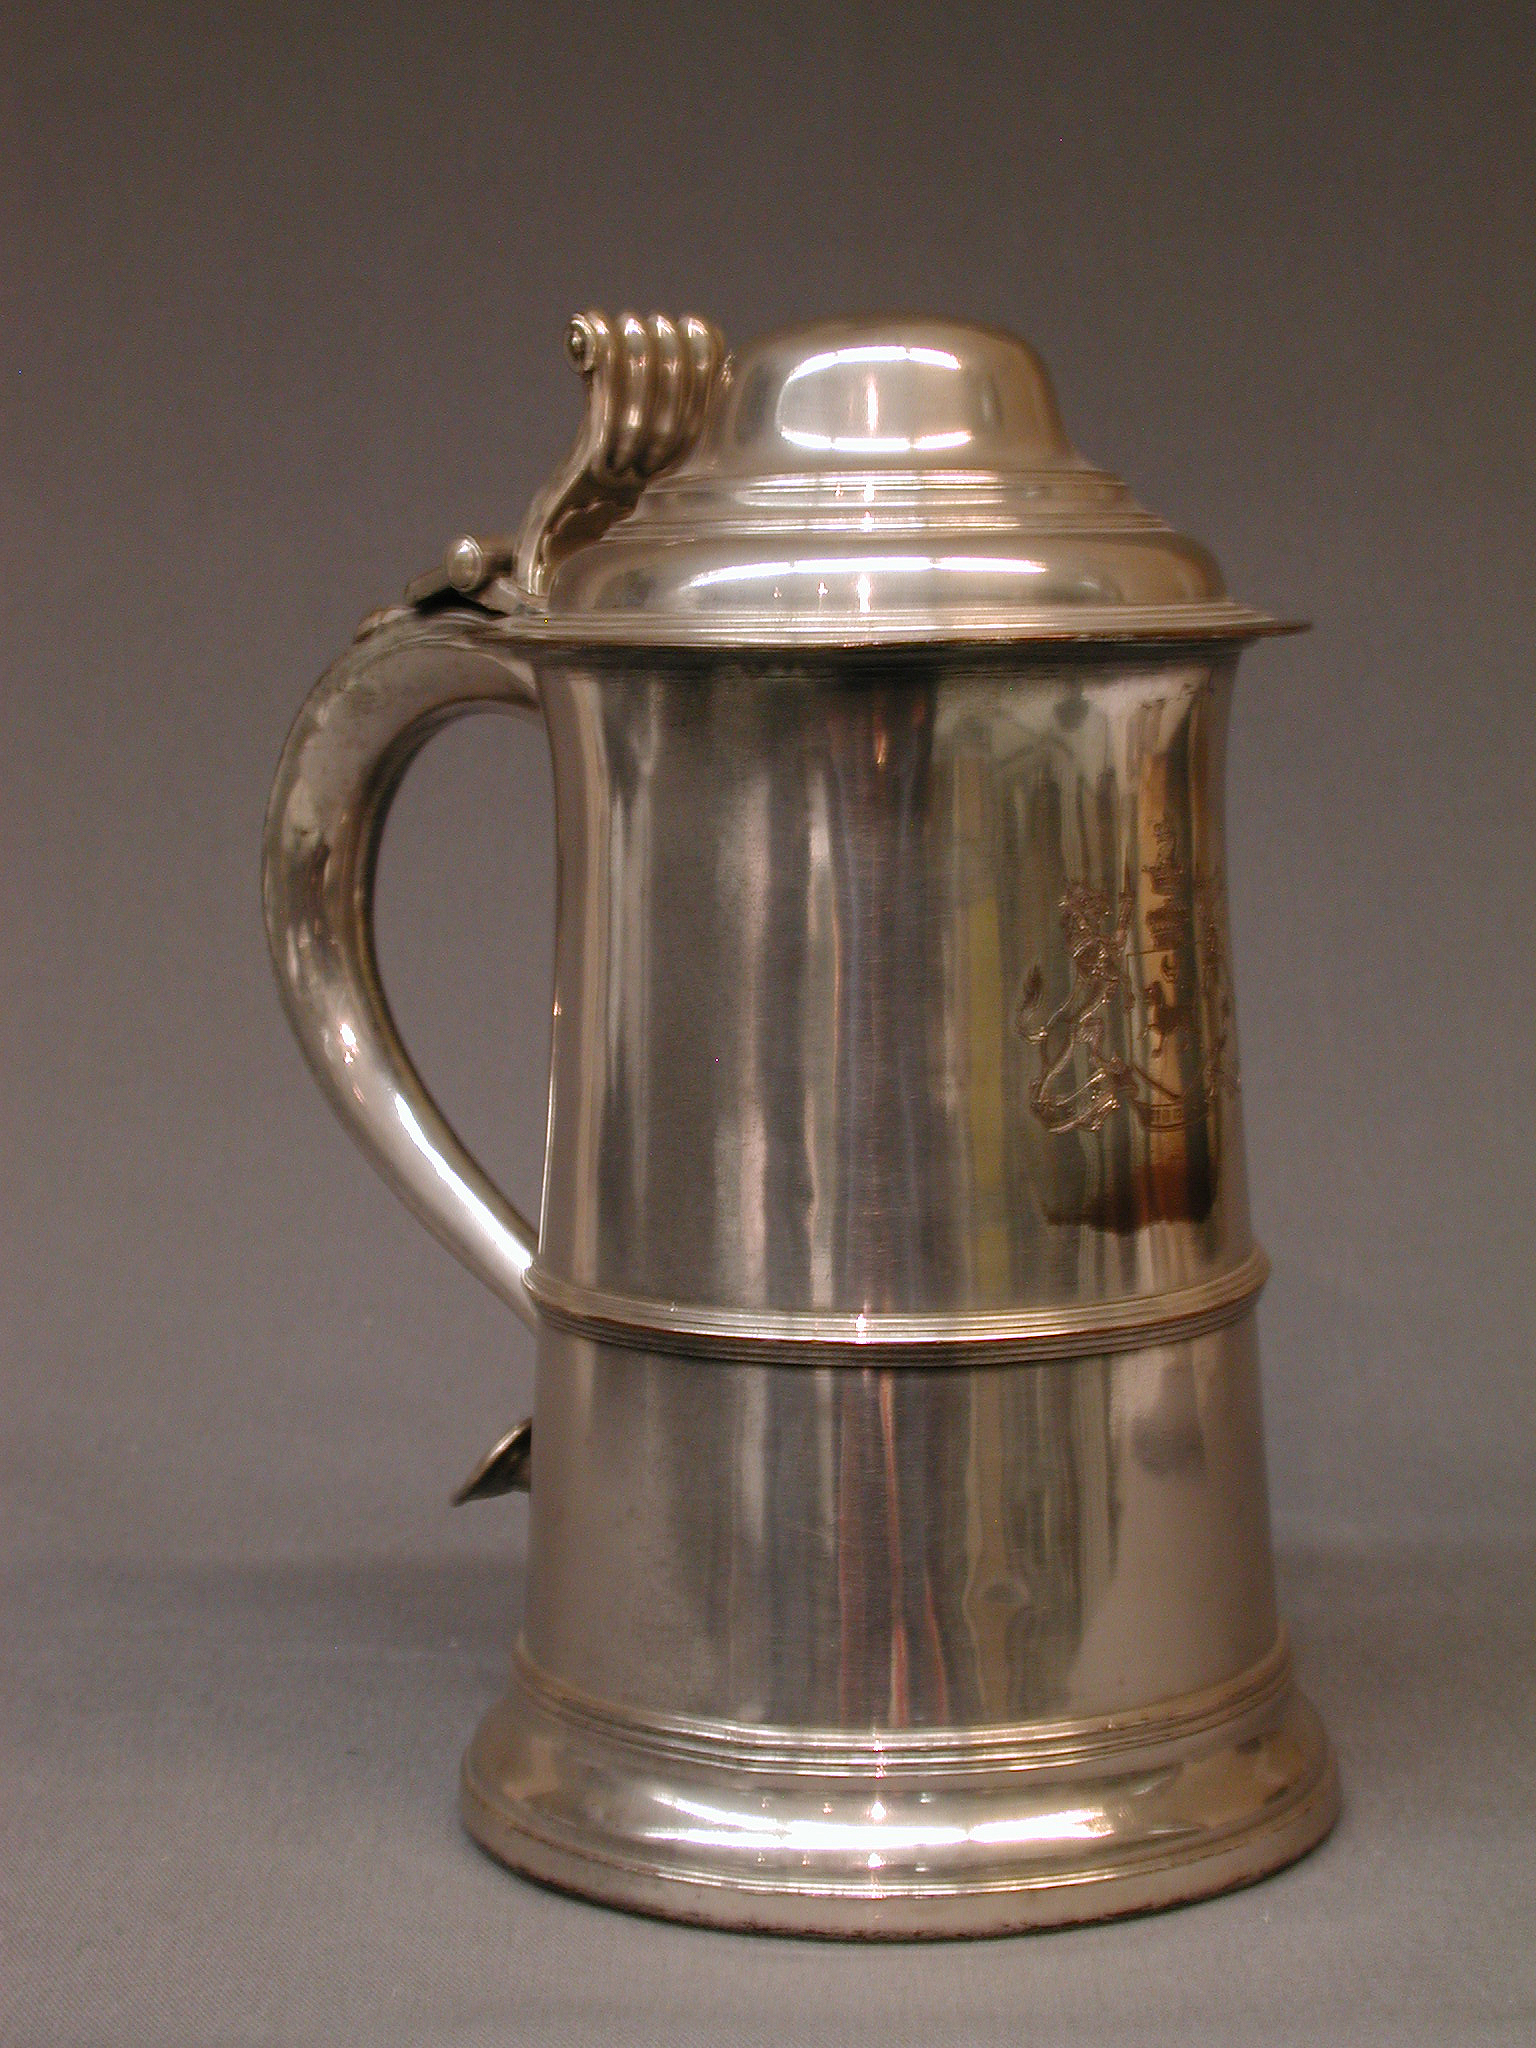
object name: tankard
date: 1790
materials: metal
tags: lions,coat of arms